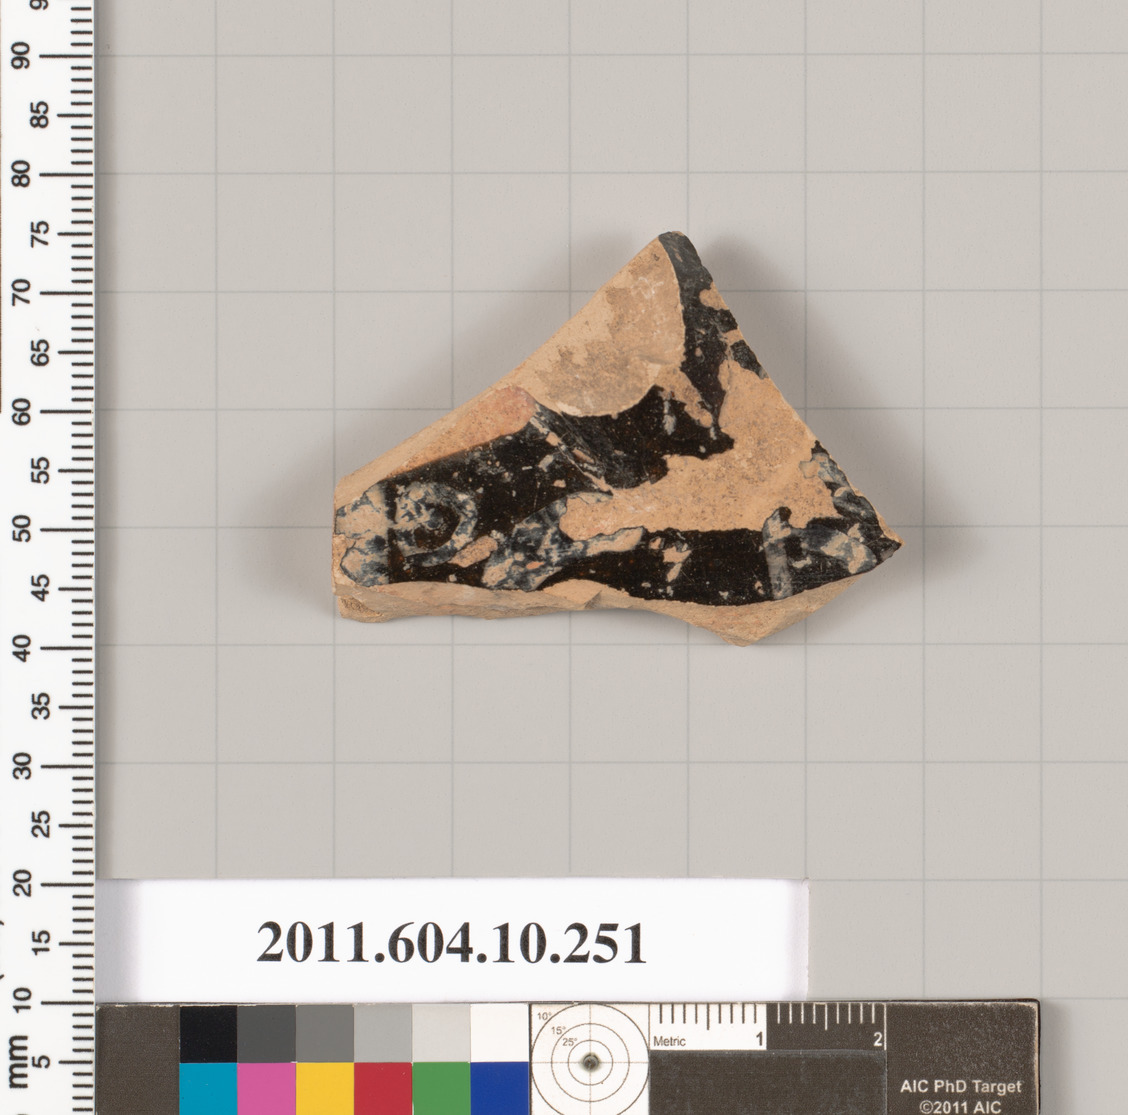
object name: skyphos fragment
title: Terracotta fragment from a skyphos (deep drinking cup)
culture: etruscan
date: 434-368 BCE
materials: terracotta